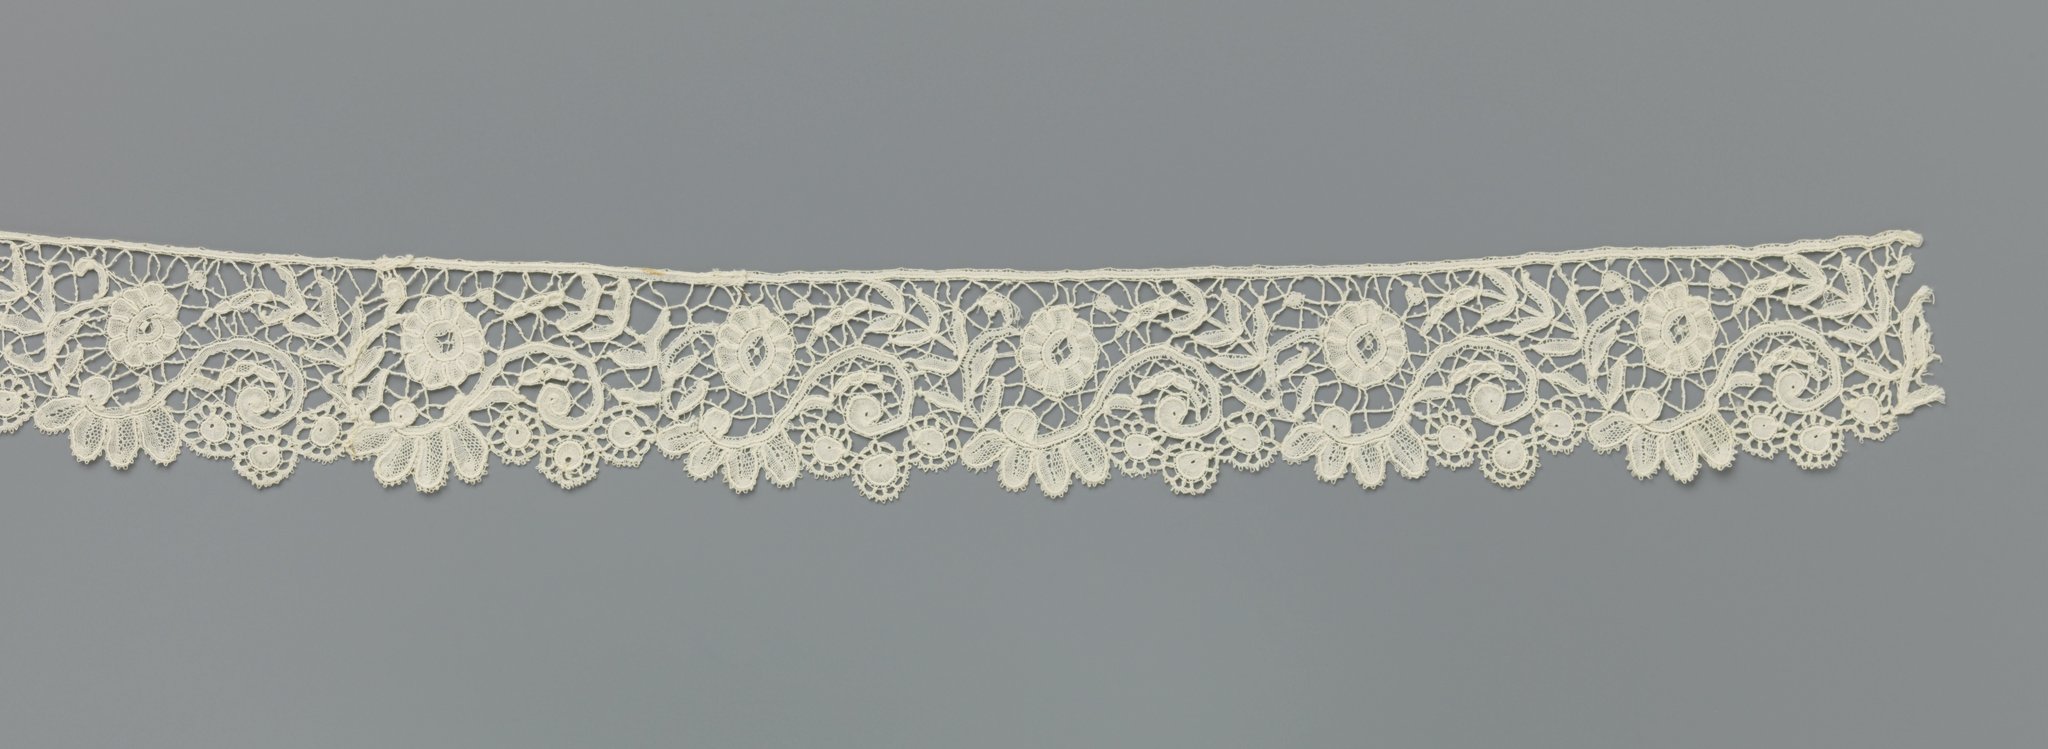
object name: strip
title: Strook kloskant met s-ranken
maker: Anonymous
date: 1875-1899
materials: linen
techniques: lace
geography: netherlands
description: Strook naturelkleurige kloskant: duchesse-kant. Op een vlechtengrond staat een lopend patroon. S-ranken met een drietal madeliefjes en een randje van campanes vormen de schulpen en eindigen in een voluut met enkelvoudig roosje.